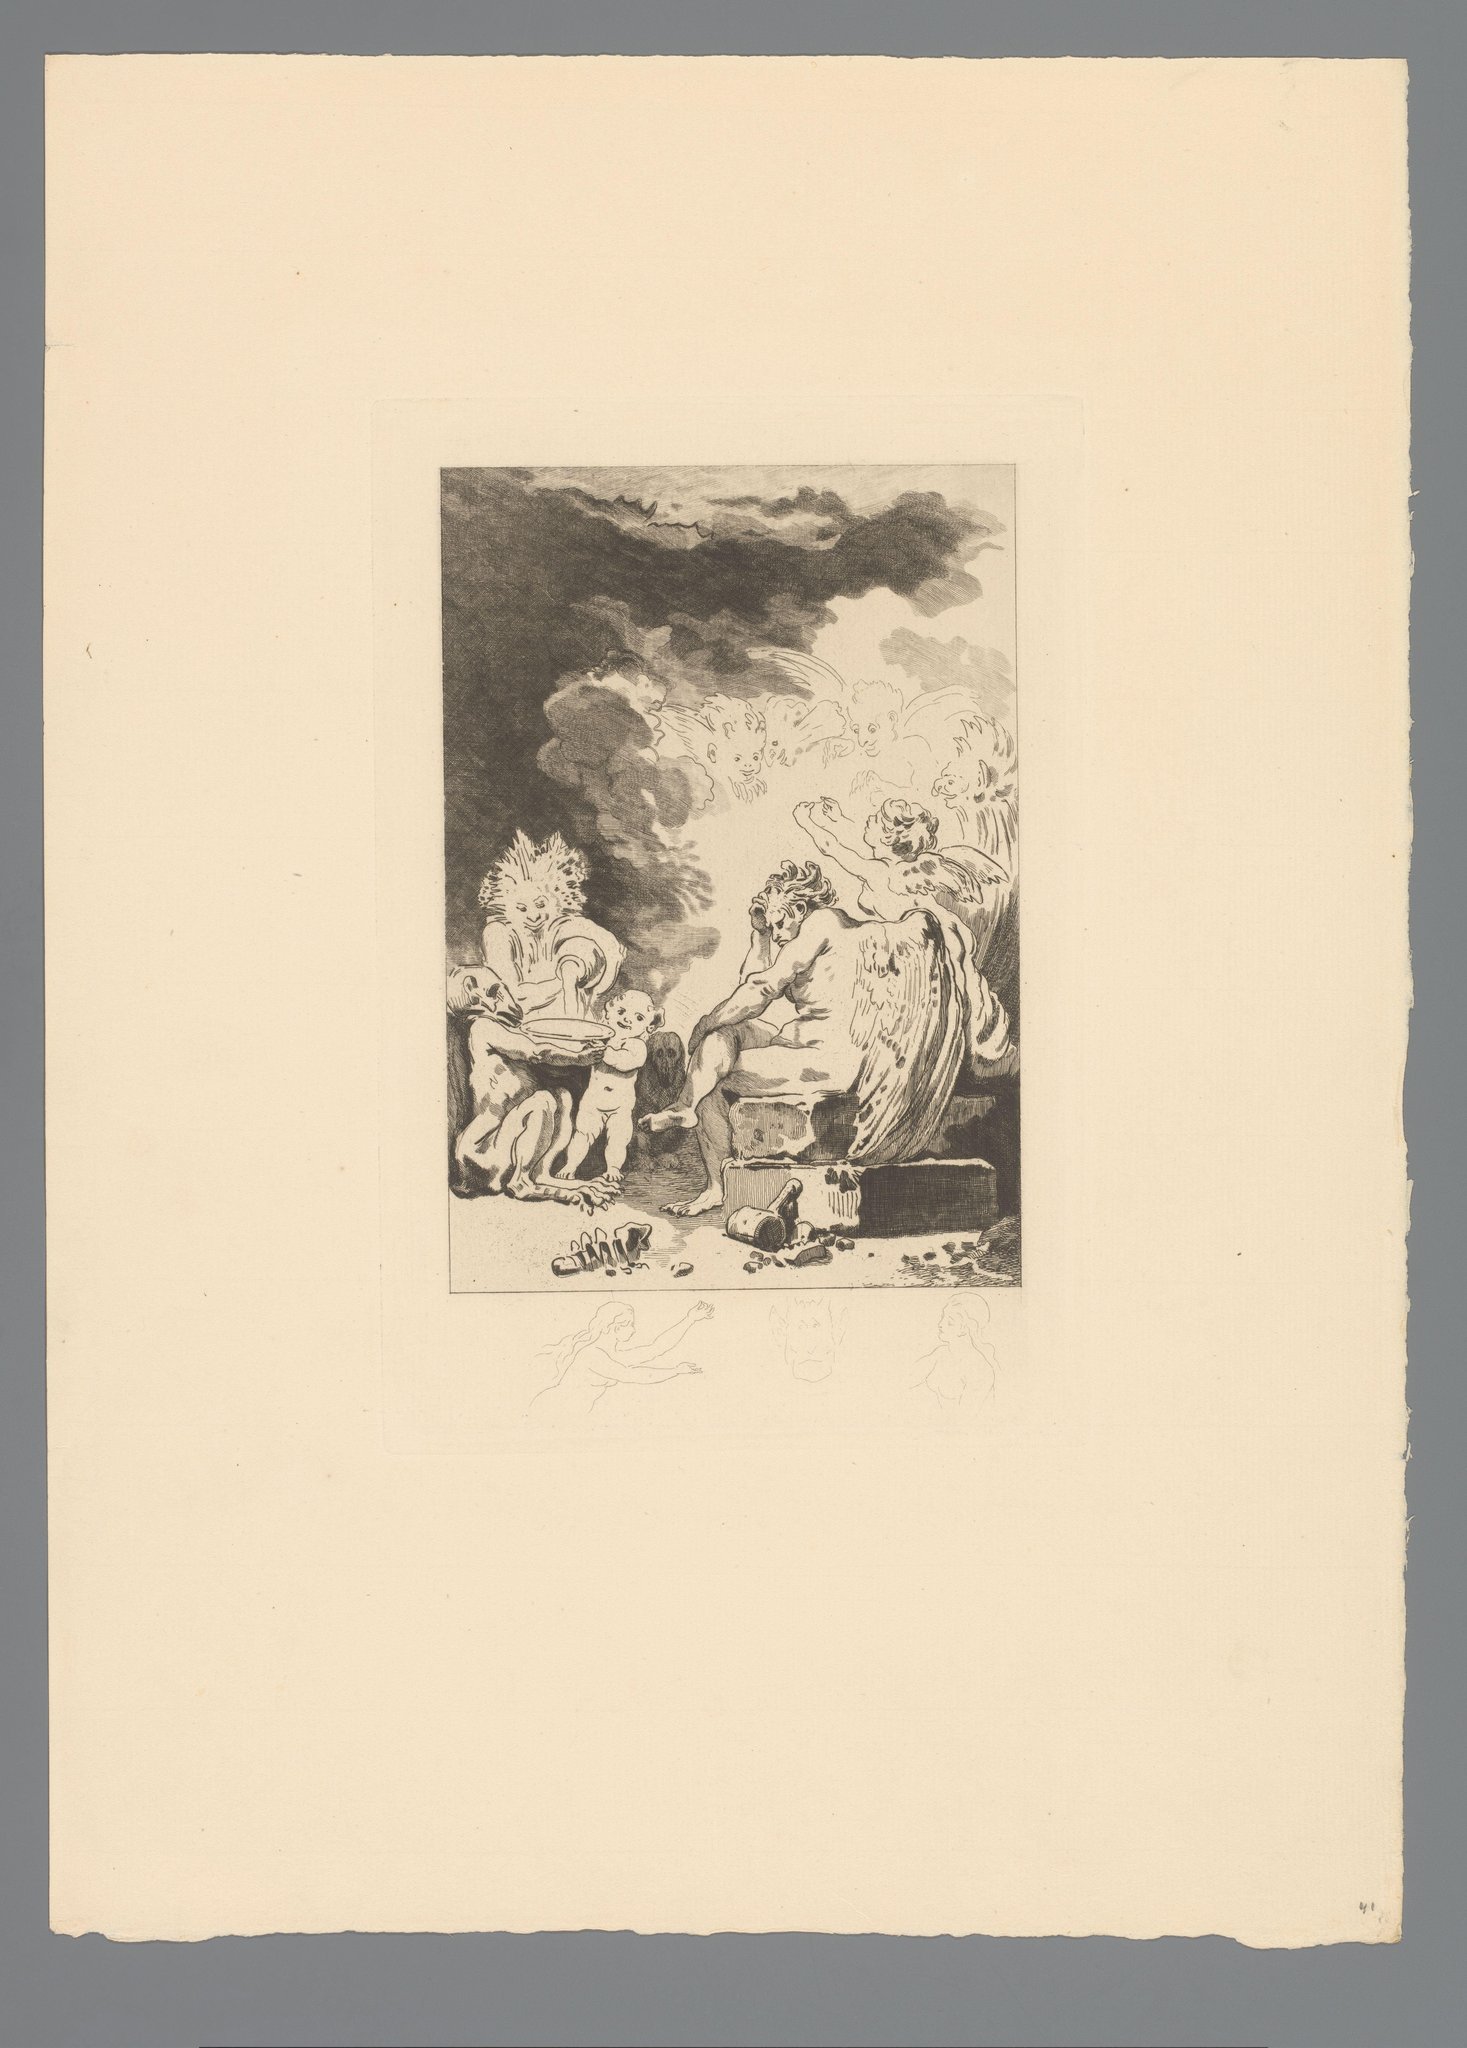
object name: photomechanical print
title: Figures des Contes de La Fontaine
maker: Anonymous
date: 1880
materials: paper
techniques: photoaquatint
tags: devil(s) and demons, angels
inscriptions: collector's mark:, collector's mark: Lugt 2228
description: Martial Potémont maakte etsen naar de tekeningen van Fragonard, die zich bevonden in een manuscript in de collectie van de verzamelaar Eugène Paillet. Rouquette bood hem aan de tekeningen zo exact mogelijk in prent te laten brengen door Martial Potémont: dit resulteerde in een serie van 57 etsen. Vervolgens werden deze gereproduceerd door middel van heliogravure. Deze omslag betreft een editie voor de letter, "Eau forte pure", de 1e staat van 3 waar men uit kon kiezen bij deze serie.